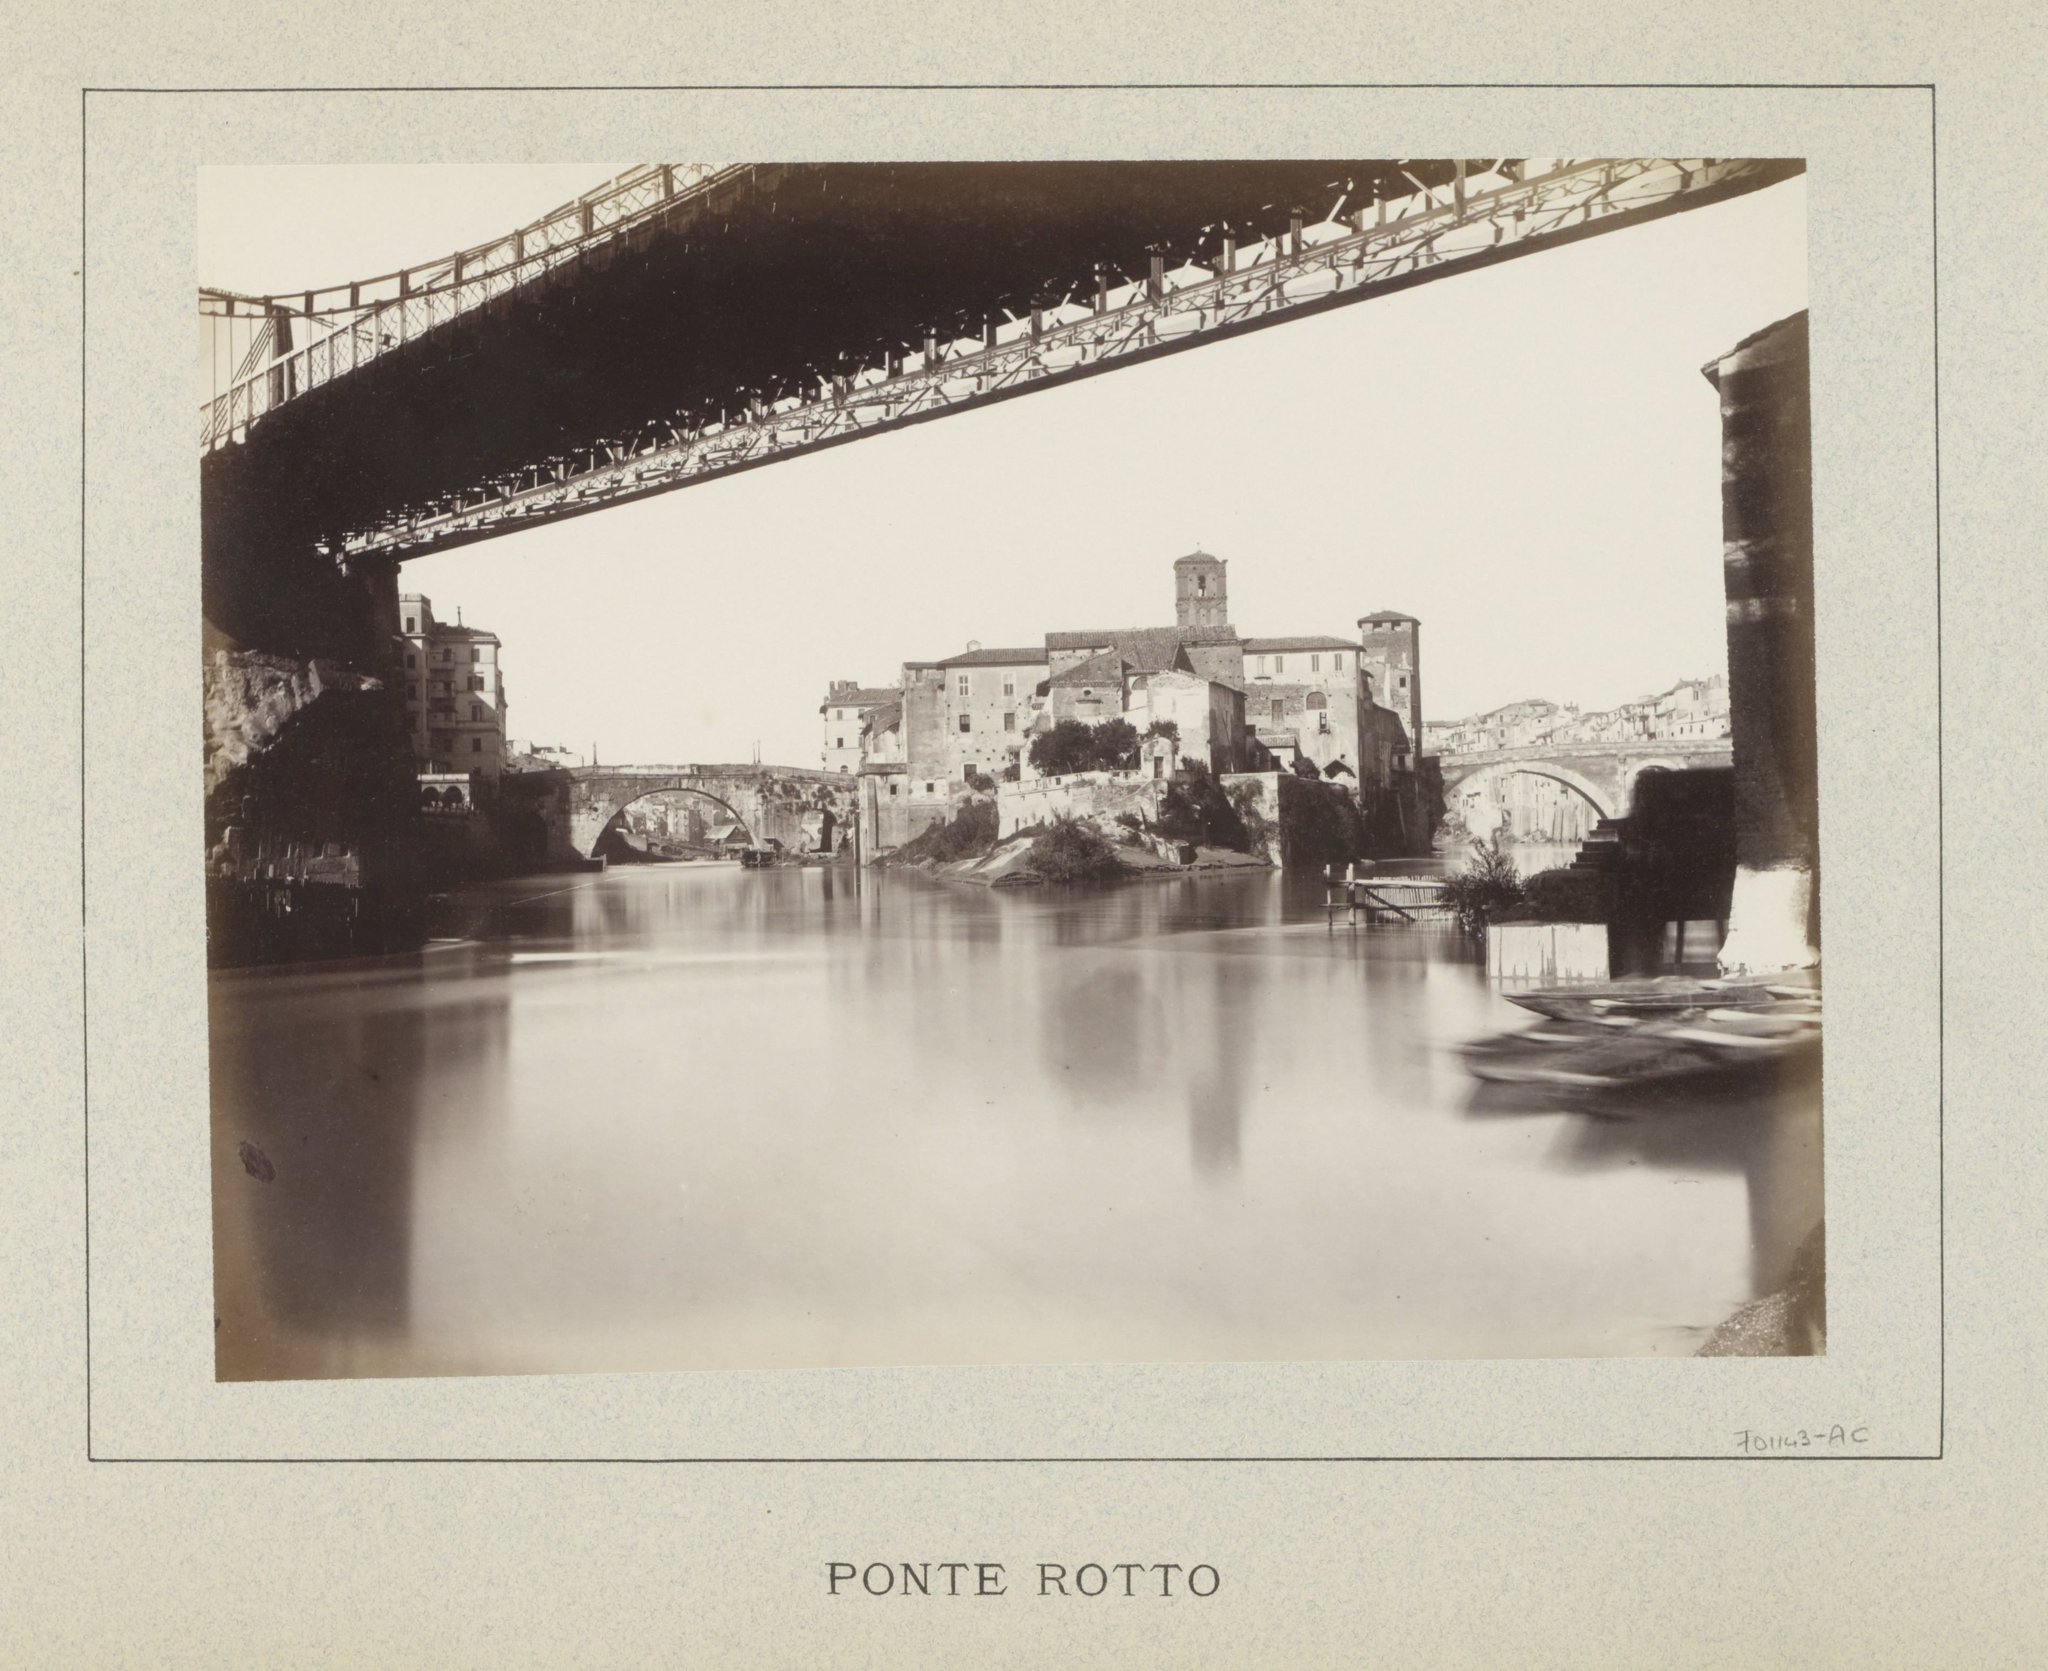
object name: photograph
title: Ponte Rotto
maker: Anonymous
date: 1860-1887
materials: photographic support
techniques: albumen print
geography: rome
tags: island, landscape with bridge, viaduct or aqueduct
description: Onderdeel van Fotoalbum met opnames van bezienswaardigheden en kunstwerken in Rome.